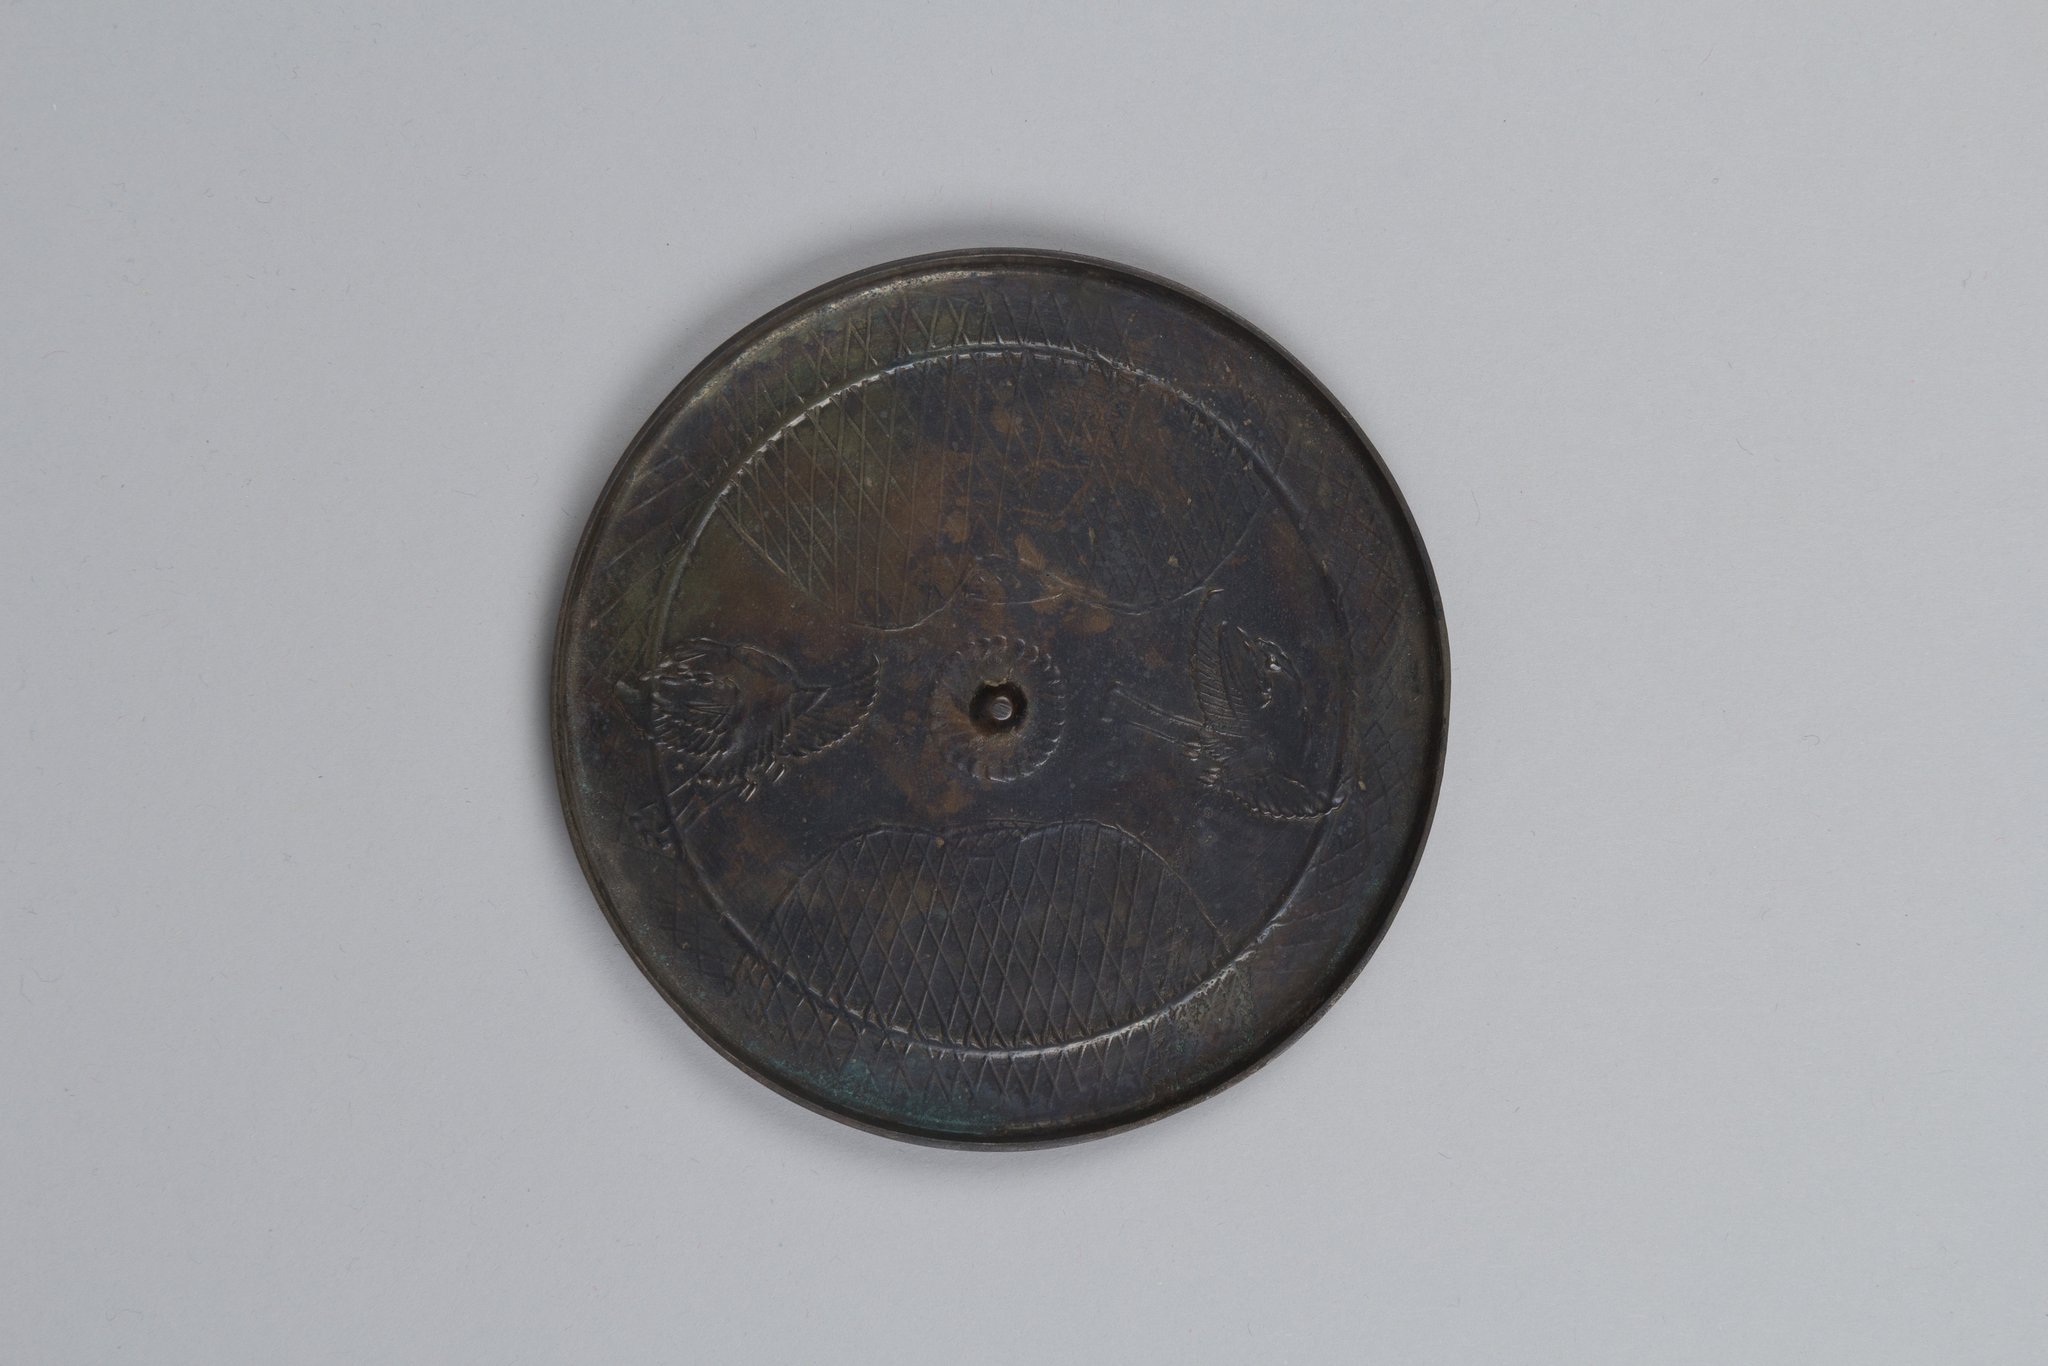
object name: mirror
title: Mirror With Decoration of Flying Birds and Fishnets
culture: japanese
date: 1101-1200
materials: bronze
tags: birds